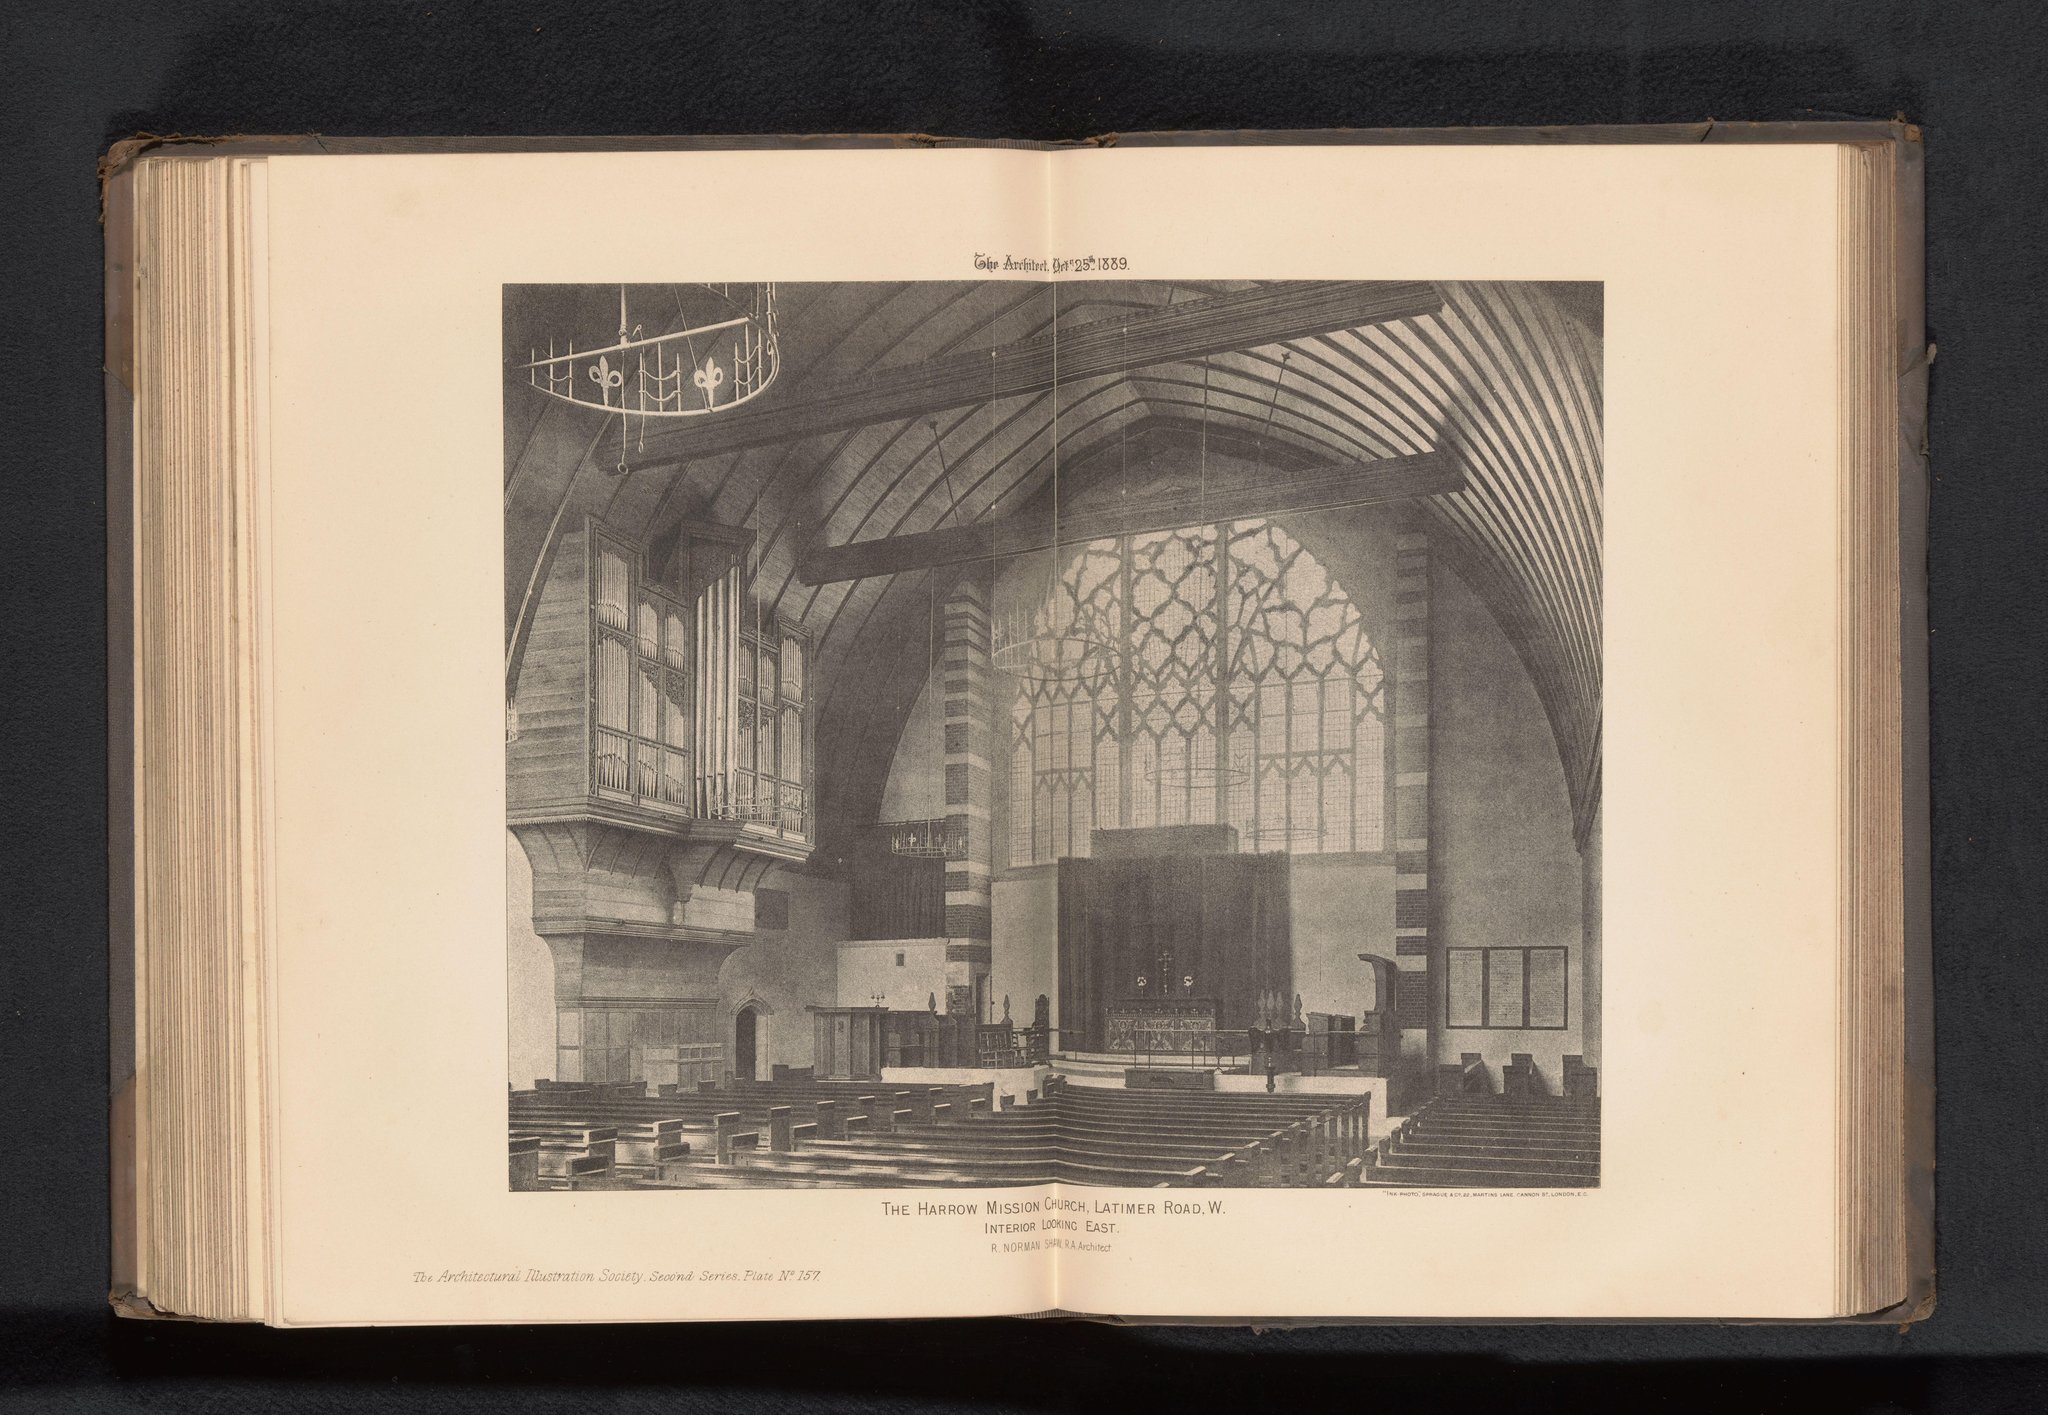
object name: page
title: Interieur met orgel van de Church of the Holy Trinity op Latimer Road te Londen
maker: Anonymous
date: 1884-1889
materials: paper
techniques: photolithography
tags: church organ, interior of church, london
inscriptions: inscription: ‘Interior Looking East/ R. Norman Shaw, R.A. Architect/ The Architectural Illustration Society. Second Series. Plate No.157’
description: Prent op achtste ongenummerde pagina na pagina 238.